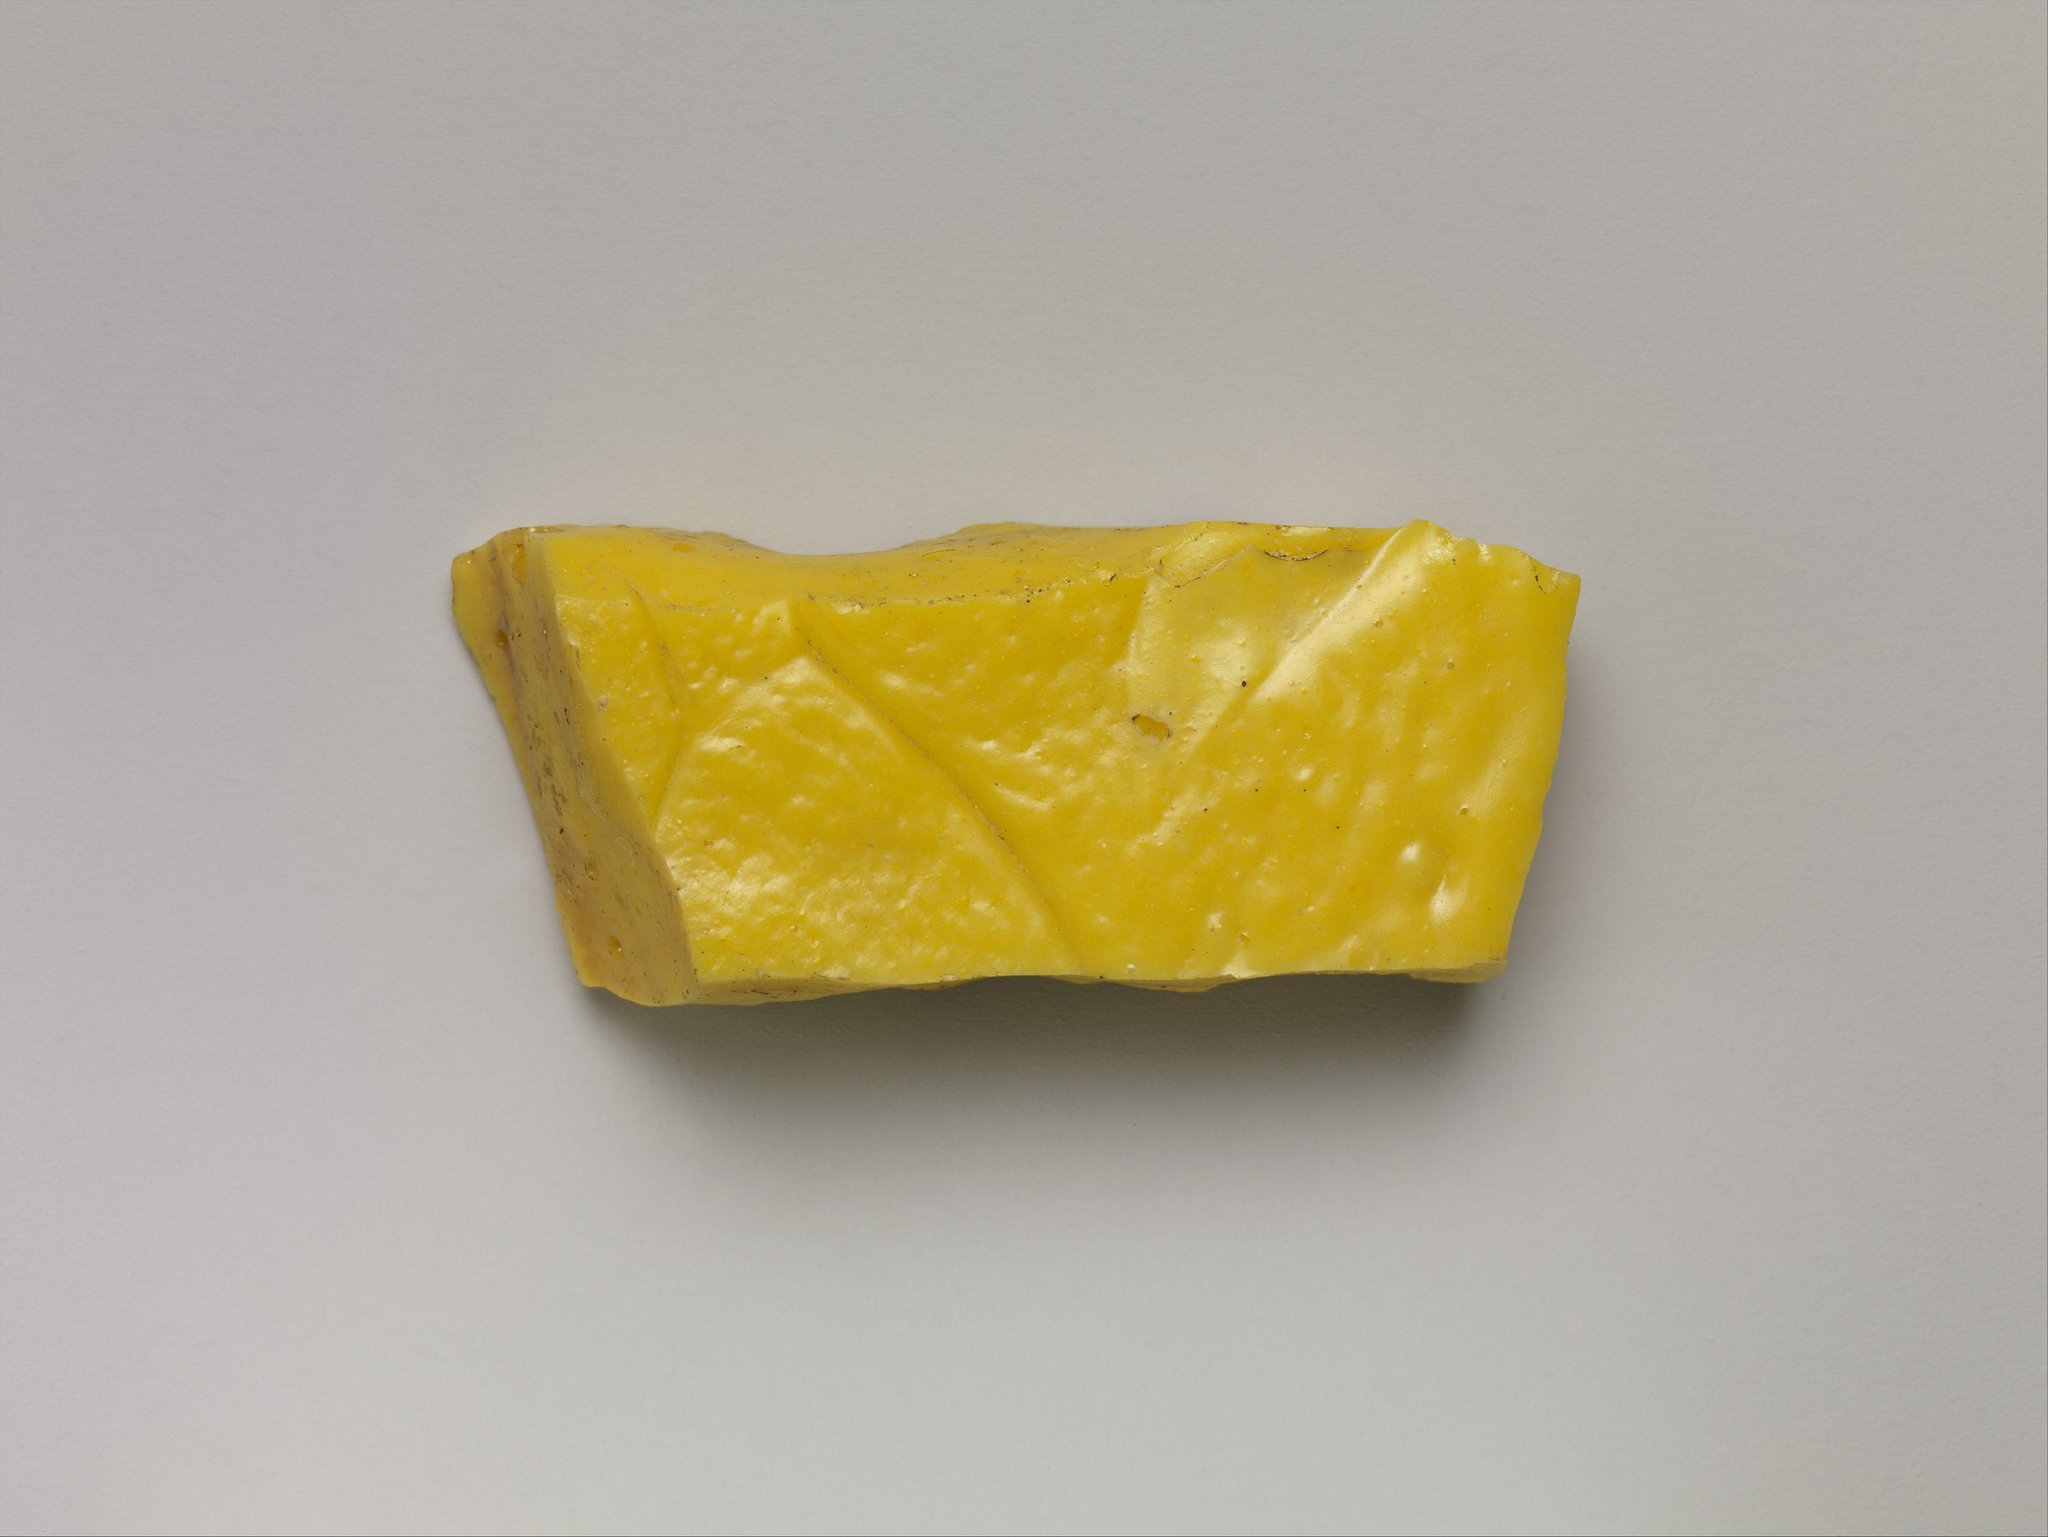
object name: fragment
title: Fragment from sample set of Chinese cloisonné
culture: chinese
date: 1867-1900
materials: copper alloy, enamel, glass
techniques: enamel